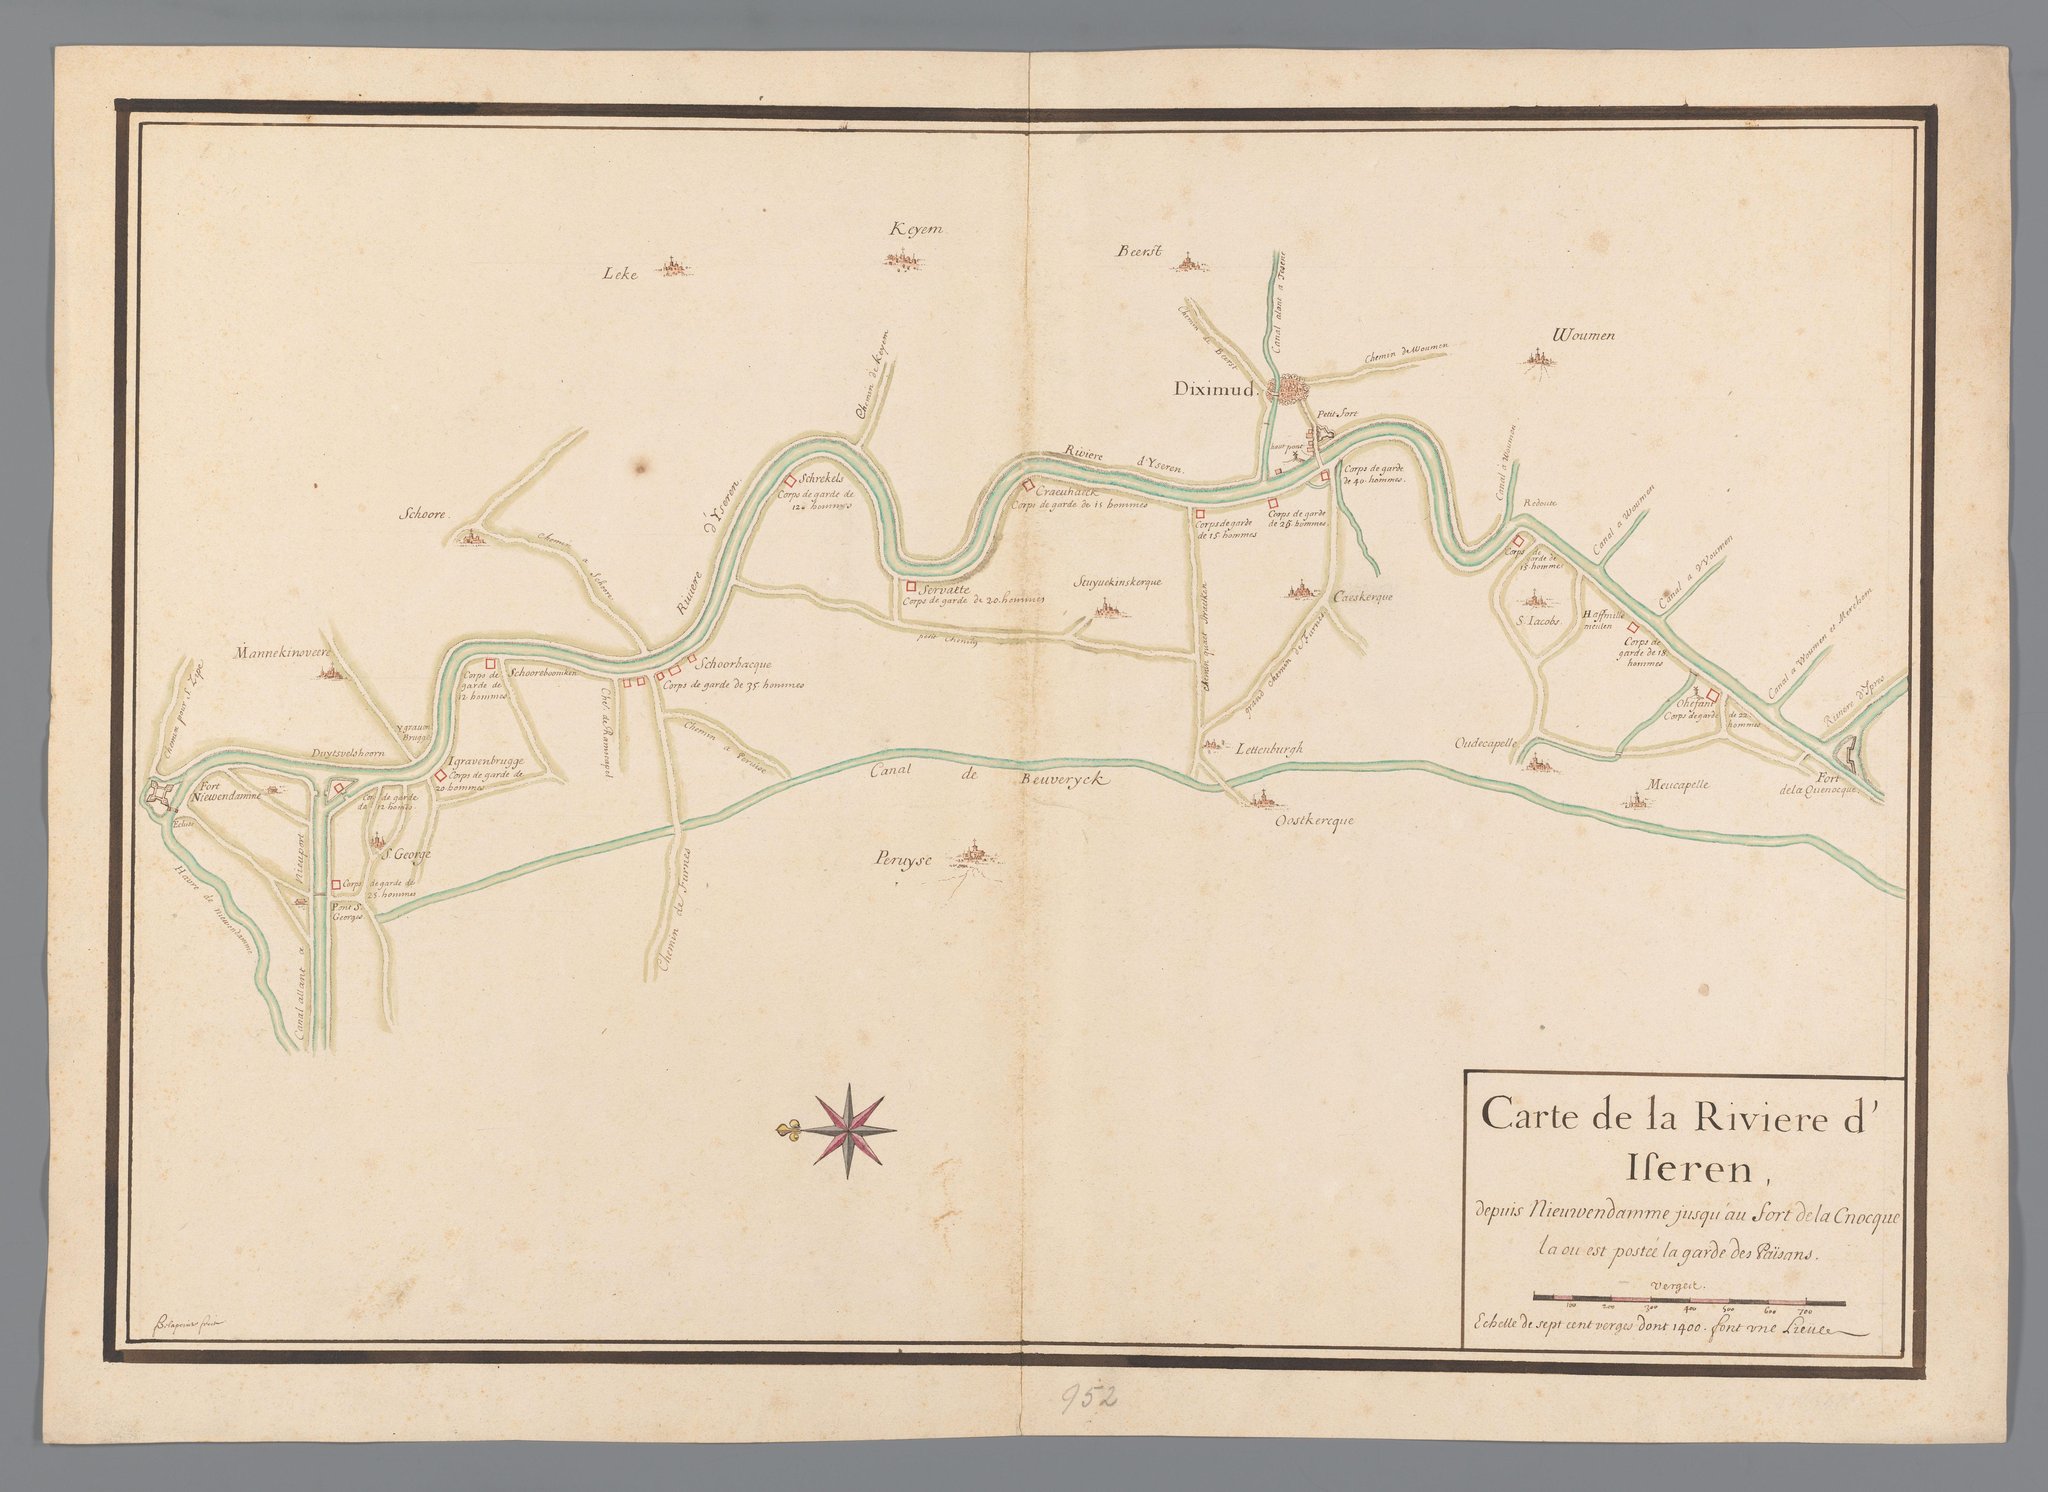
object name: drawing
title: Kaart van rivier de IJzer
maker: françois de la pointe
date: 1667-1690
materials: ink, paper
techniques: brush, hand coloring, pen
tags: river, maps, atlases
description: Kaart van rivier de IJzer met aangrenzende plaatsen. Rechtsonder titel en schaalstok.